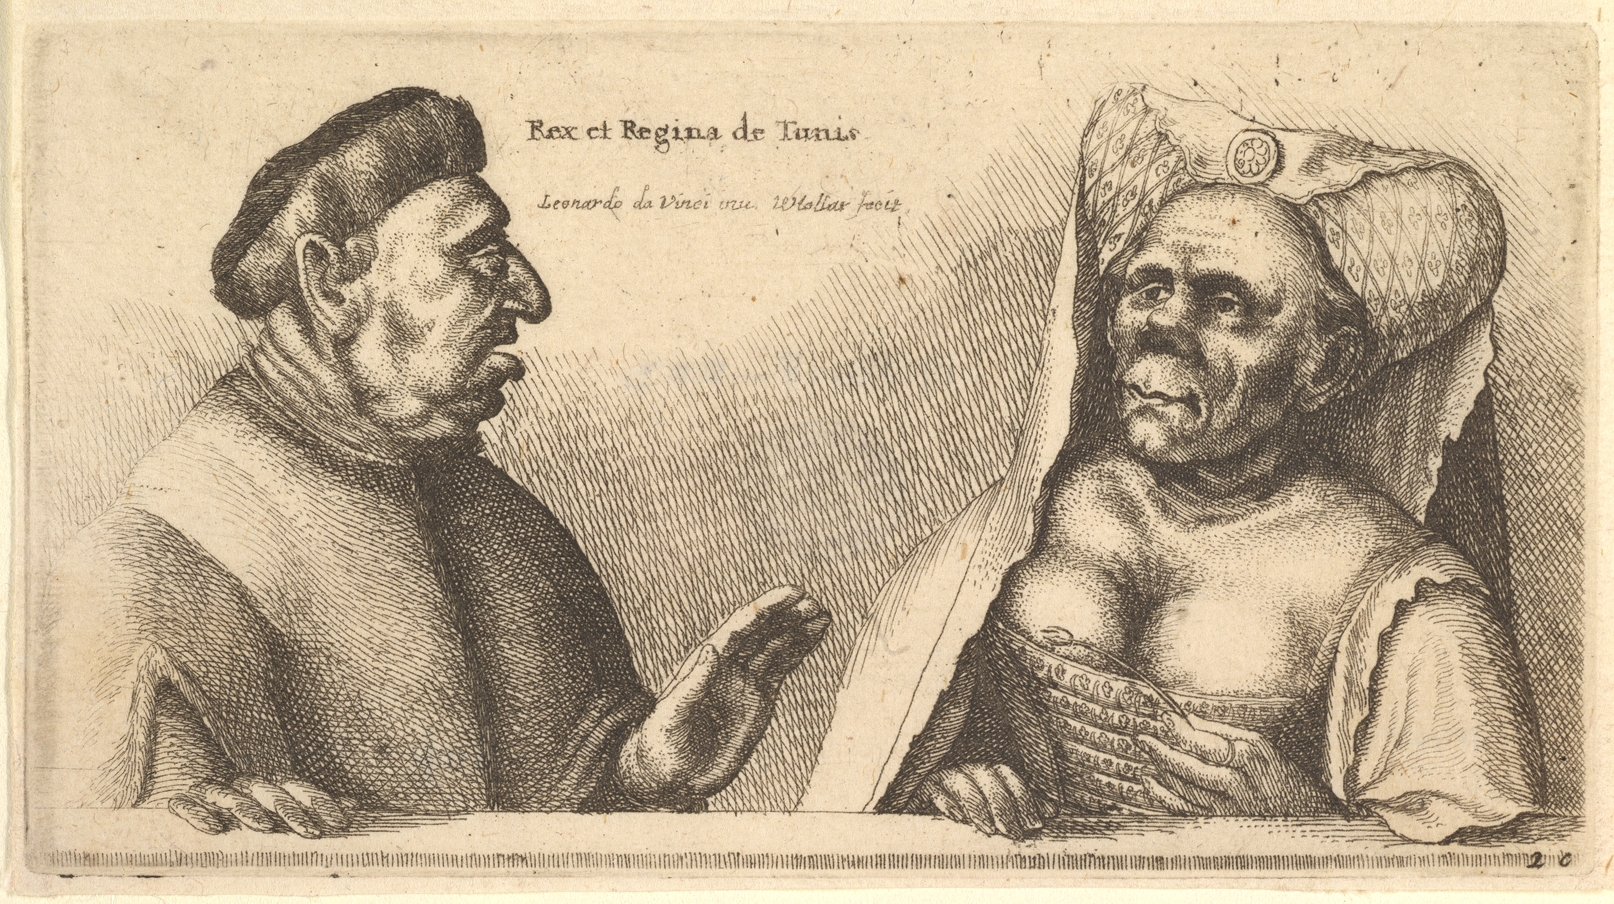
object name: print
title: Rex et Regina de Tunis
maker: wenceslaus hollar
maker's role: artist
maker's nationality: bohemian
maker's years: 1607-1677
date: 1645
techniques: etching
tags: men,women